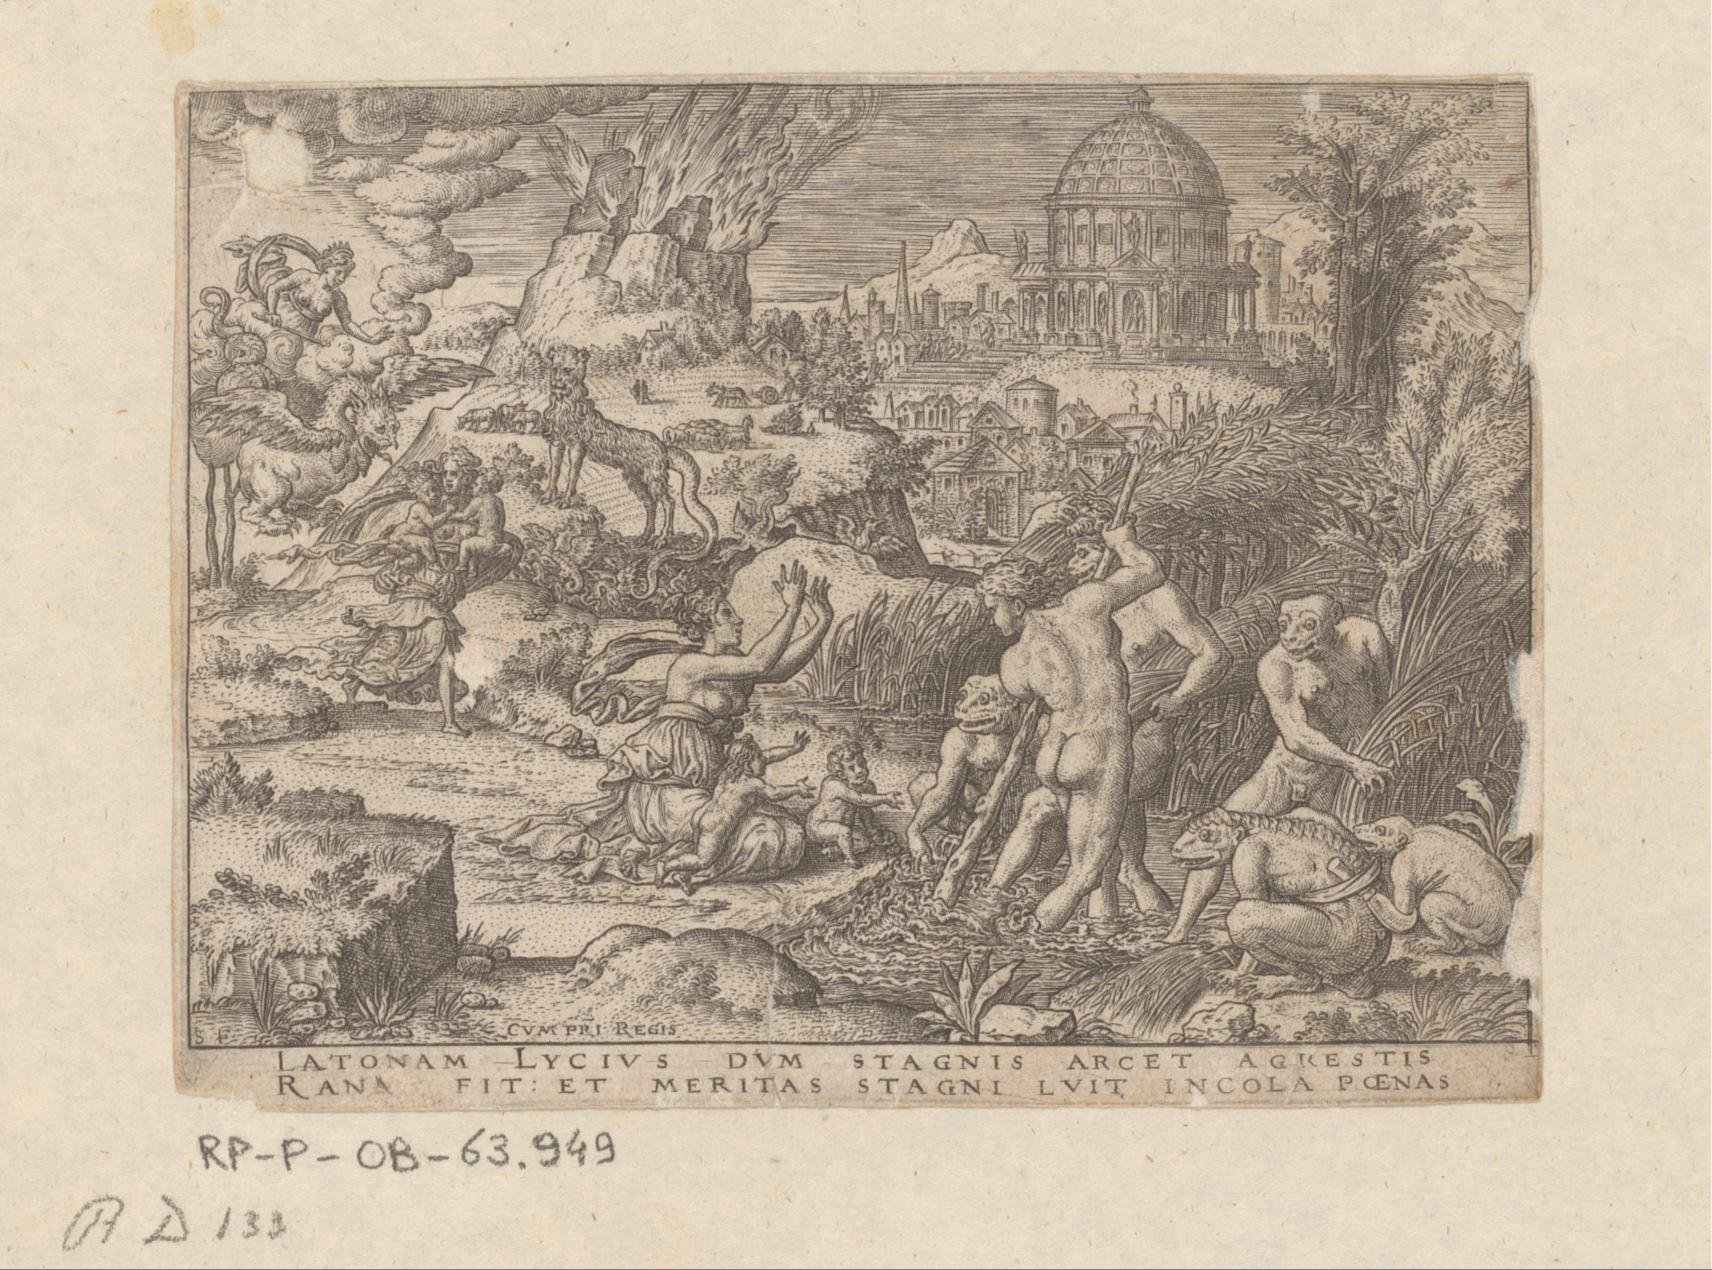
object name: print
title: Histoire d'Apollon et de Diane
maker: etienne delaune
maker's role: draughtsman, goldsmith, print maker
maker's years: 1519-1583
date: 1547-1548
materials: paper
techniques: engraving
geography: france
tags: lycian farmers changed into frogs: latona changes lycian farmers into frogs, because while they were weeding a marsh, they prevented her and her children from quenching their thirst (ovid, metamorphoses vi 369)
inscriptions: collector's mark: Lugt 240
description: Maakt deel uit van een zesdelige serie met scènes uit het verhaal van Diana en Apollo.